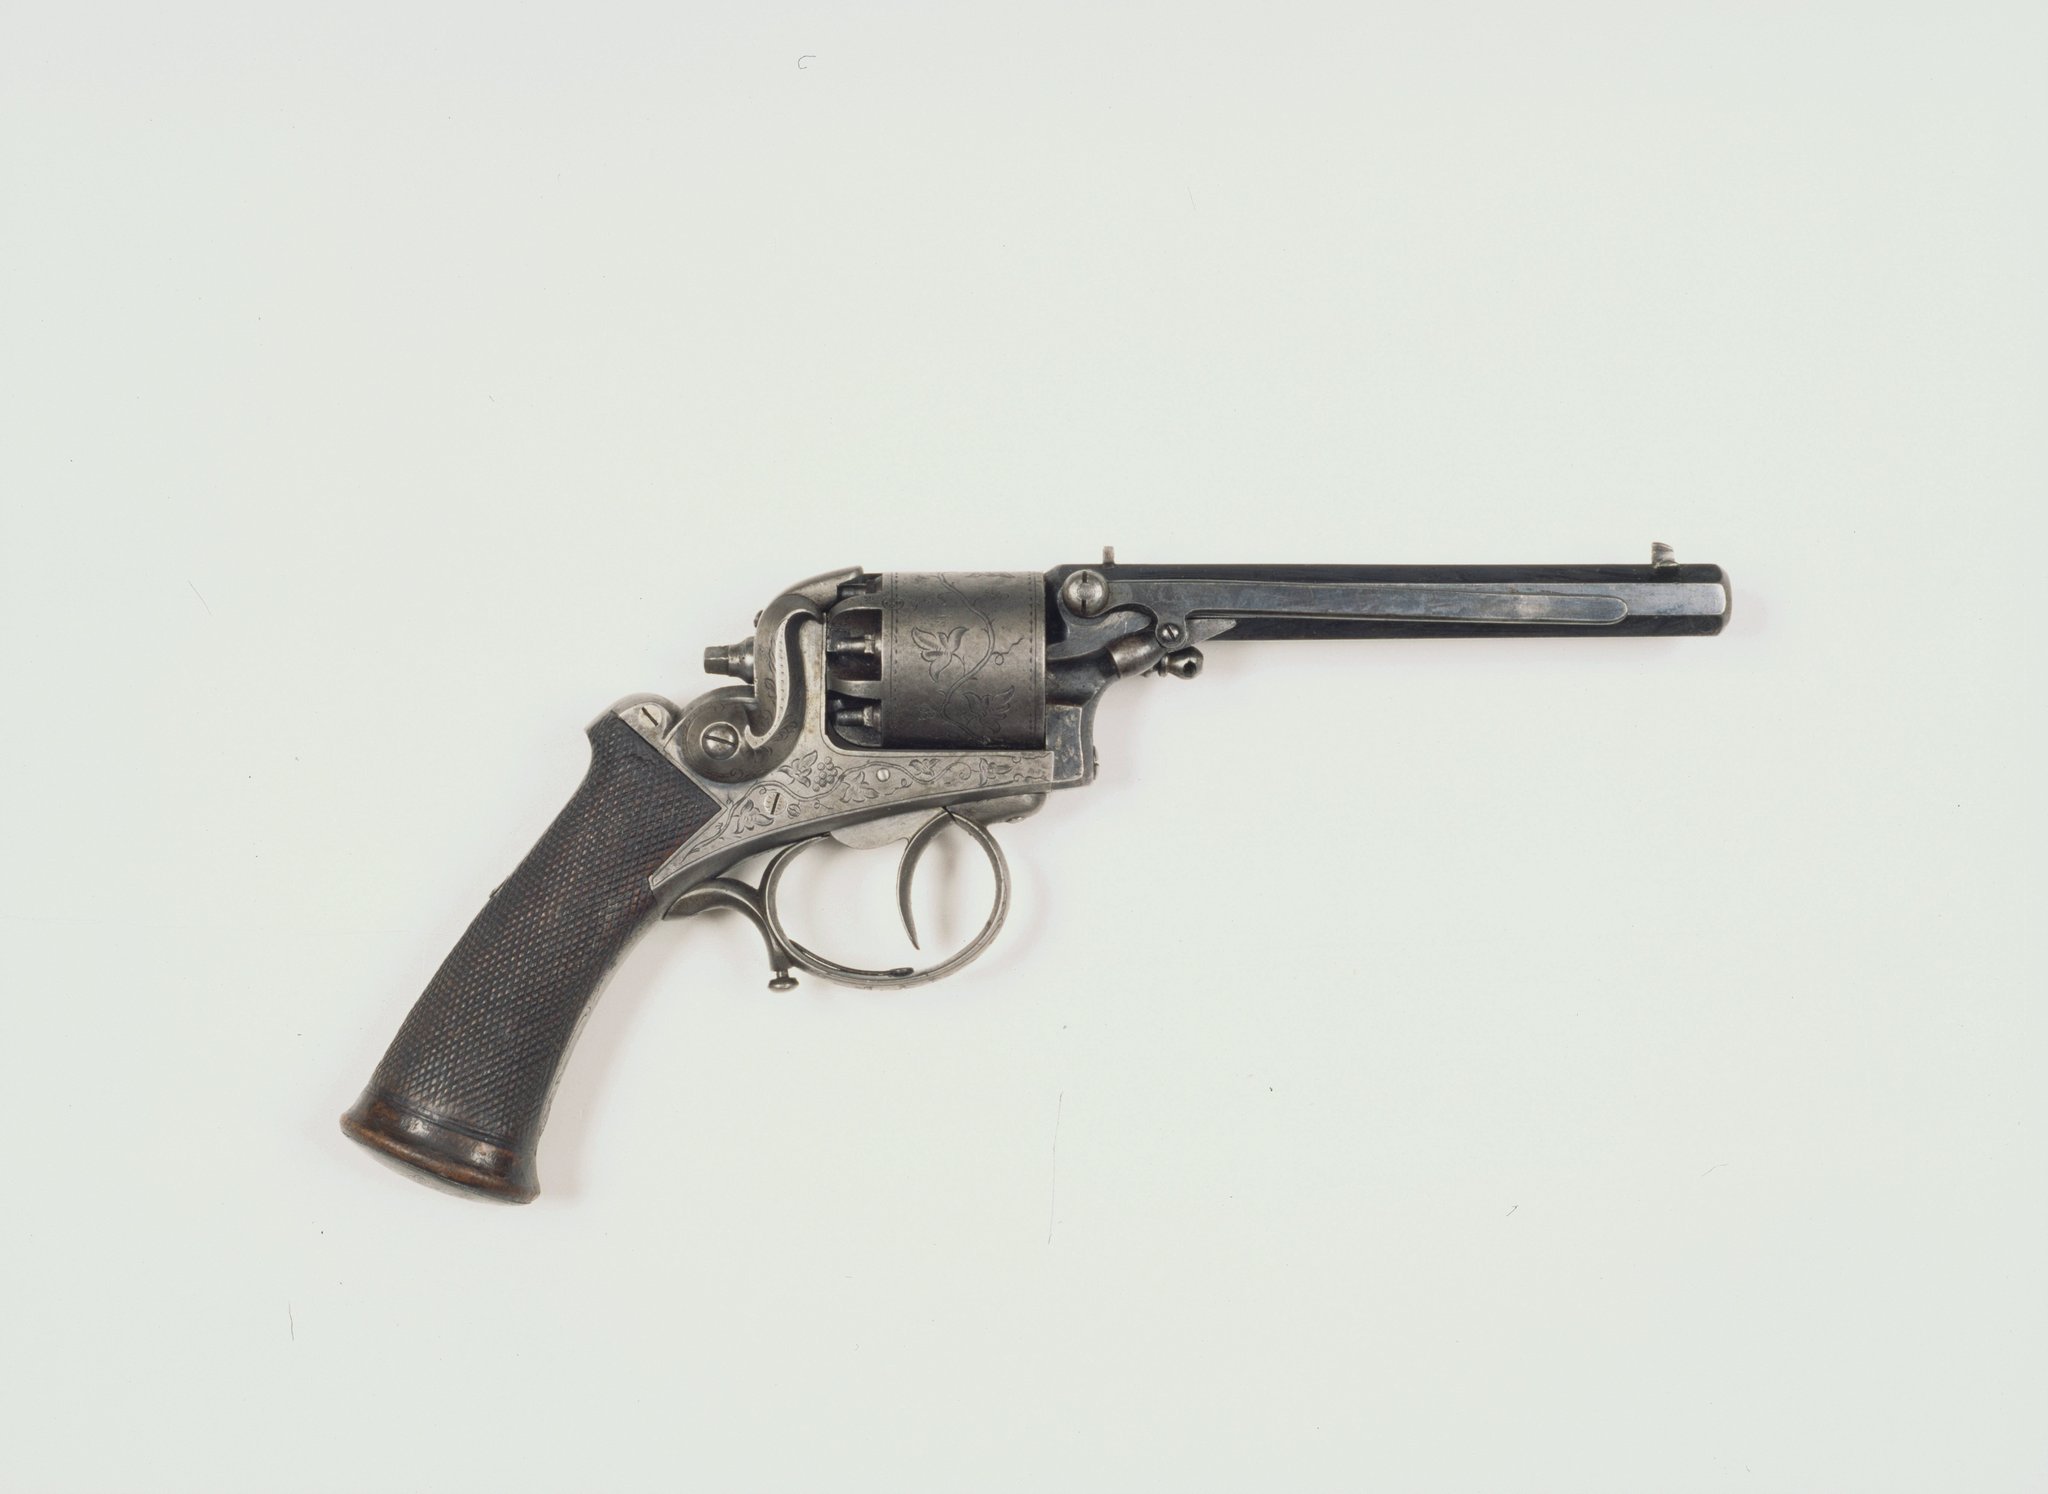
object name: revolver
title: Revolver nr. 1635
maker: Anonymous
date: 1840-1860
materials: iron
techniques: engraving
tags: the hague, albert carel baron snouckaert van schauburg, netherlands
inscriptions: : ‘no 1635’, : ‘Mangiot Brevèté comblain’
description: Revolver, systeem 'Mangiot'. Kamerlading voor zes schoten, met perscussie. Achtkantige geblauwde loop en verplaatsbare korrel en keep. Gegraveerde cylinder voor zes schoten. Gegraveerde slotkast en beslag. Op de linkerzijde van de slotkast 'Mangiot Brevèté comblain'. Afkomstig van de gepensioneerde majoor der cavalerie P.G.R. baron Snouckaert van Schauburg.